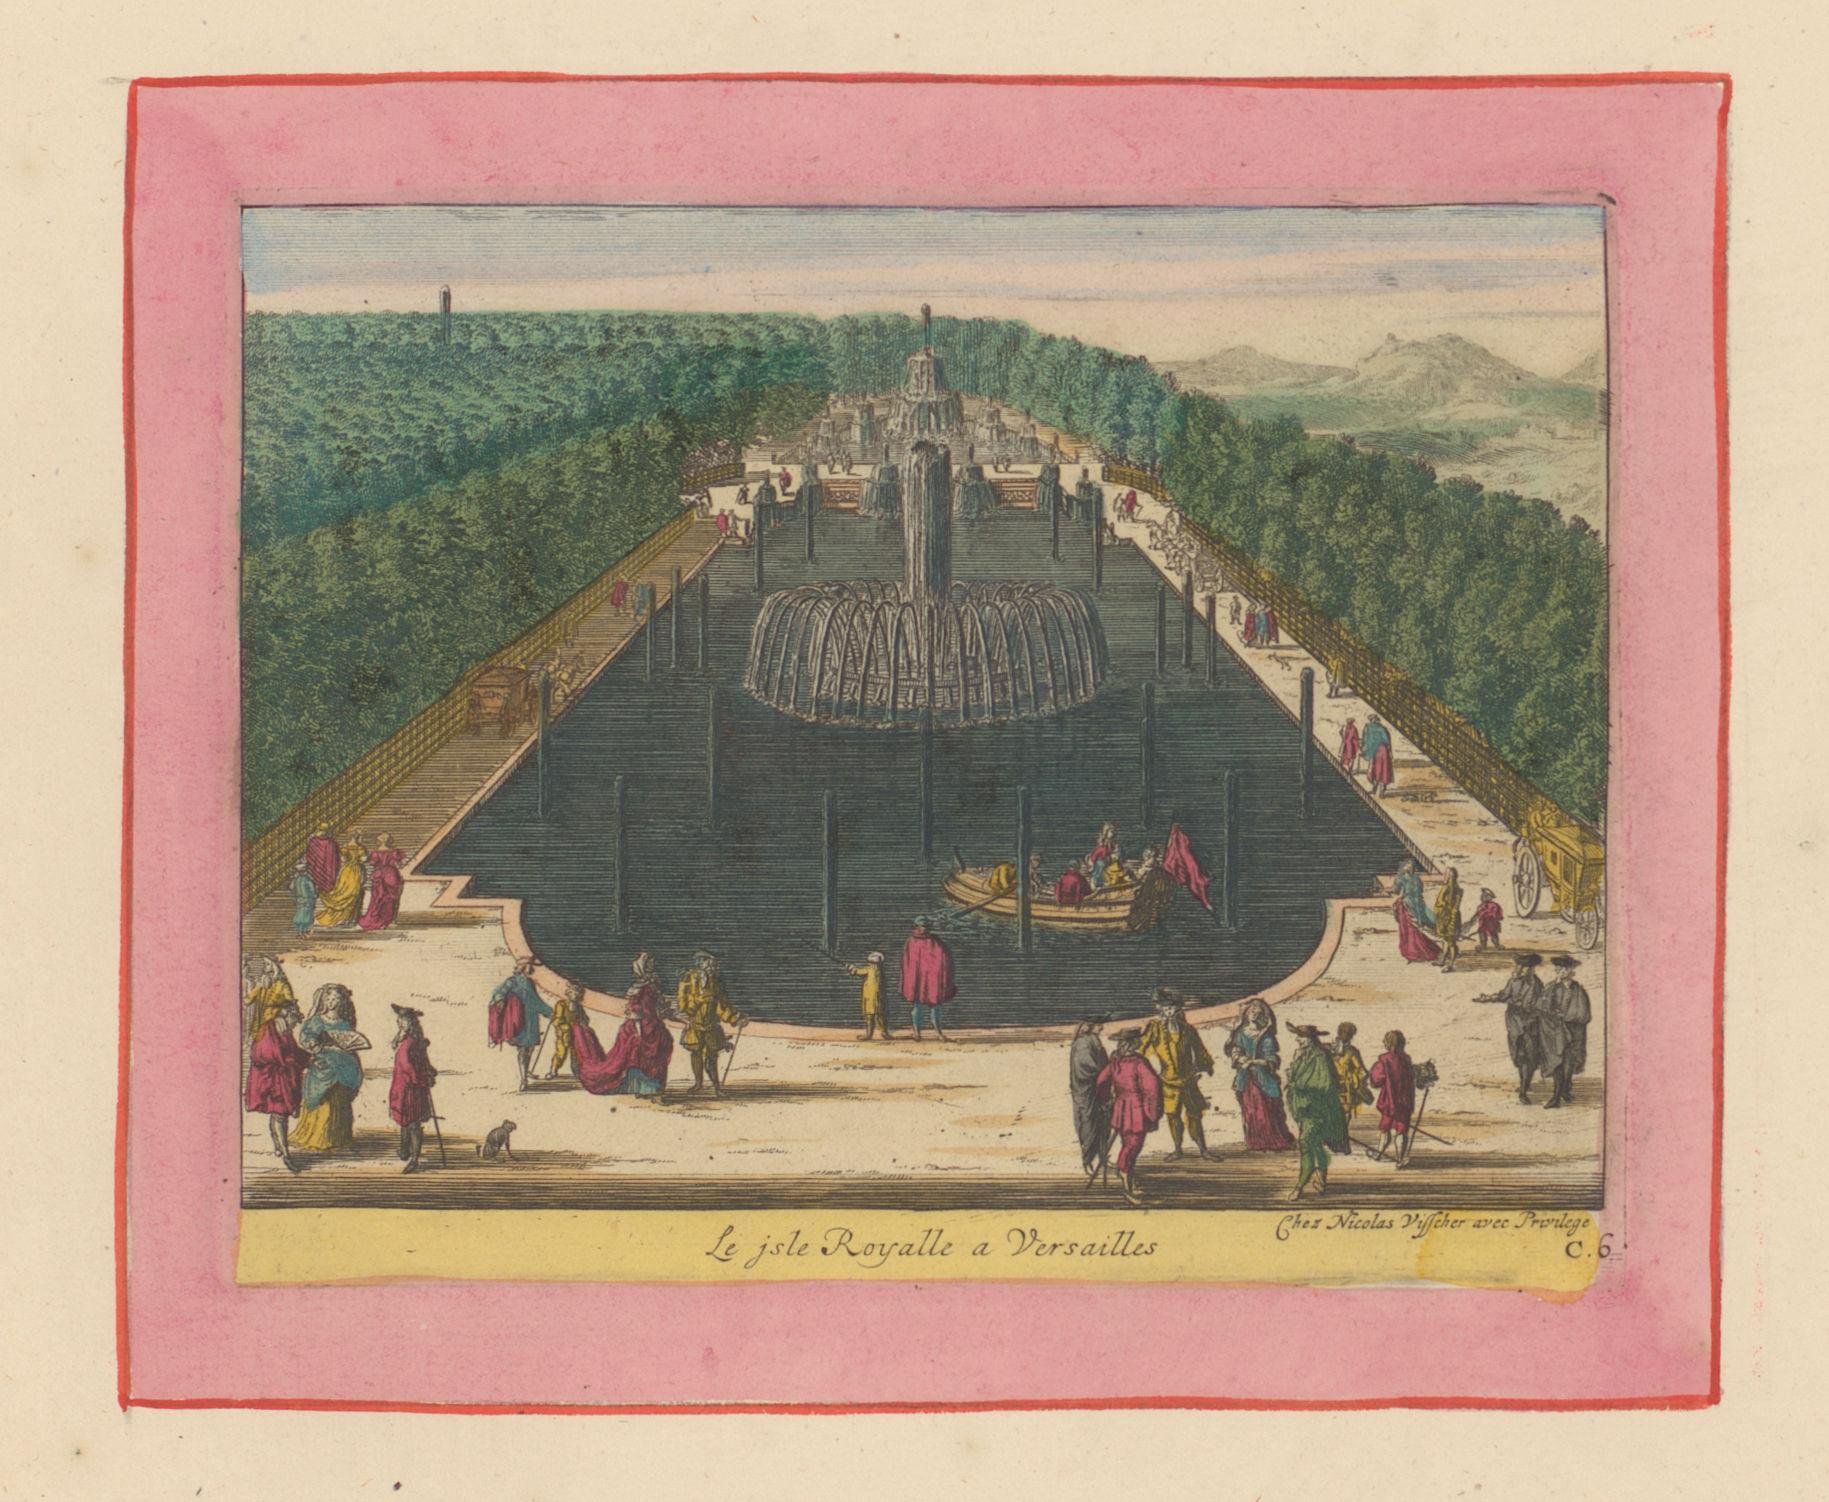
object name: print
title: Le isle Royalle a Versailles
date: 1686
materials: paper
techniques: etching, hand coloring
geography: amsterdam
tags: garden fountain, french or architectonic garden; formal garden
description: Bassin met fonteinen, Île Royale geheten, in de tuinen van Versailles. Rechtsonder het serienummer: C6. Prent maakt deel uit van een album.